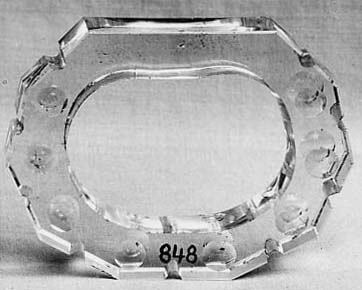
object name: ring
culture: chinese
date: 1701-1800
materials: quartz